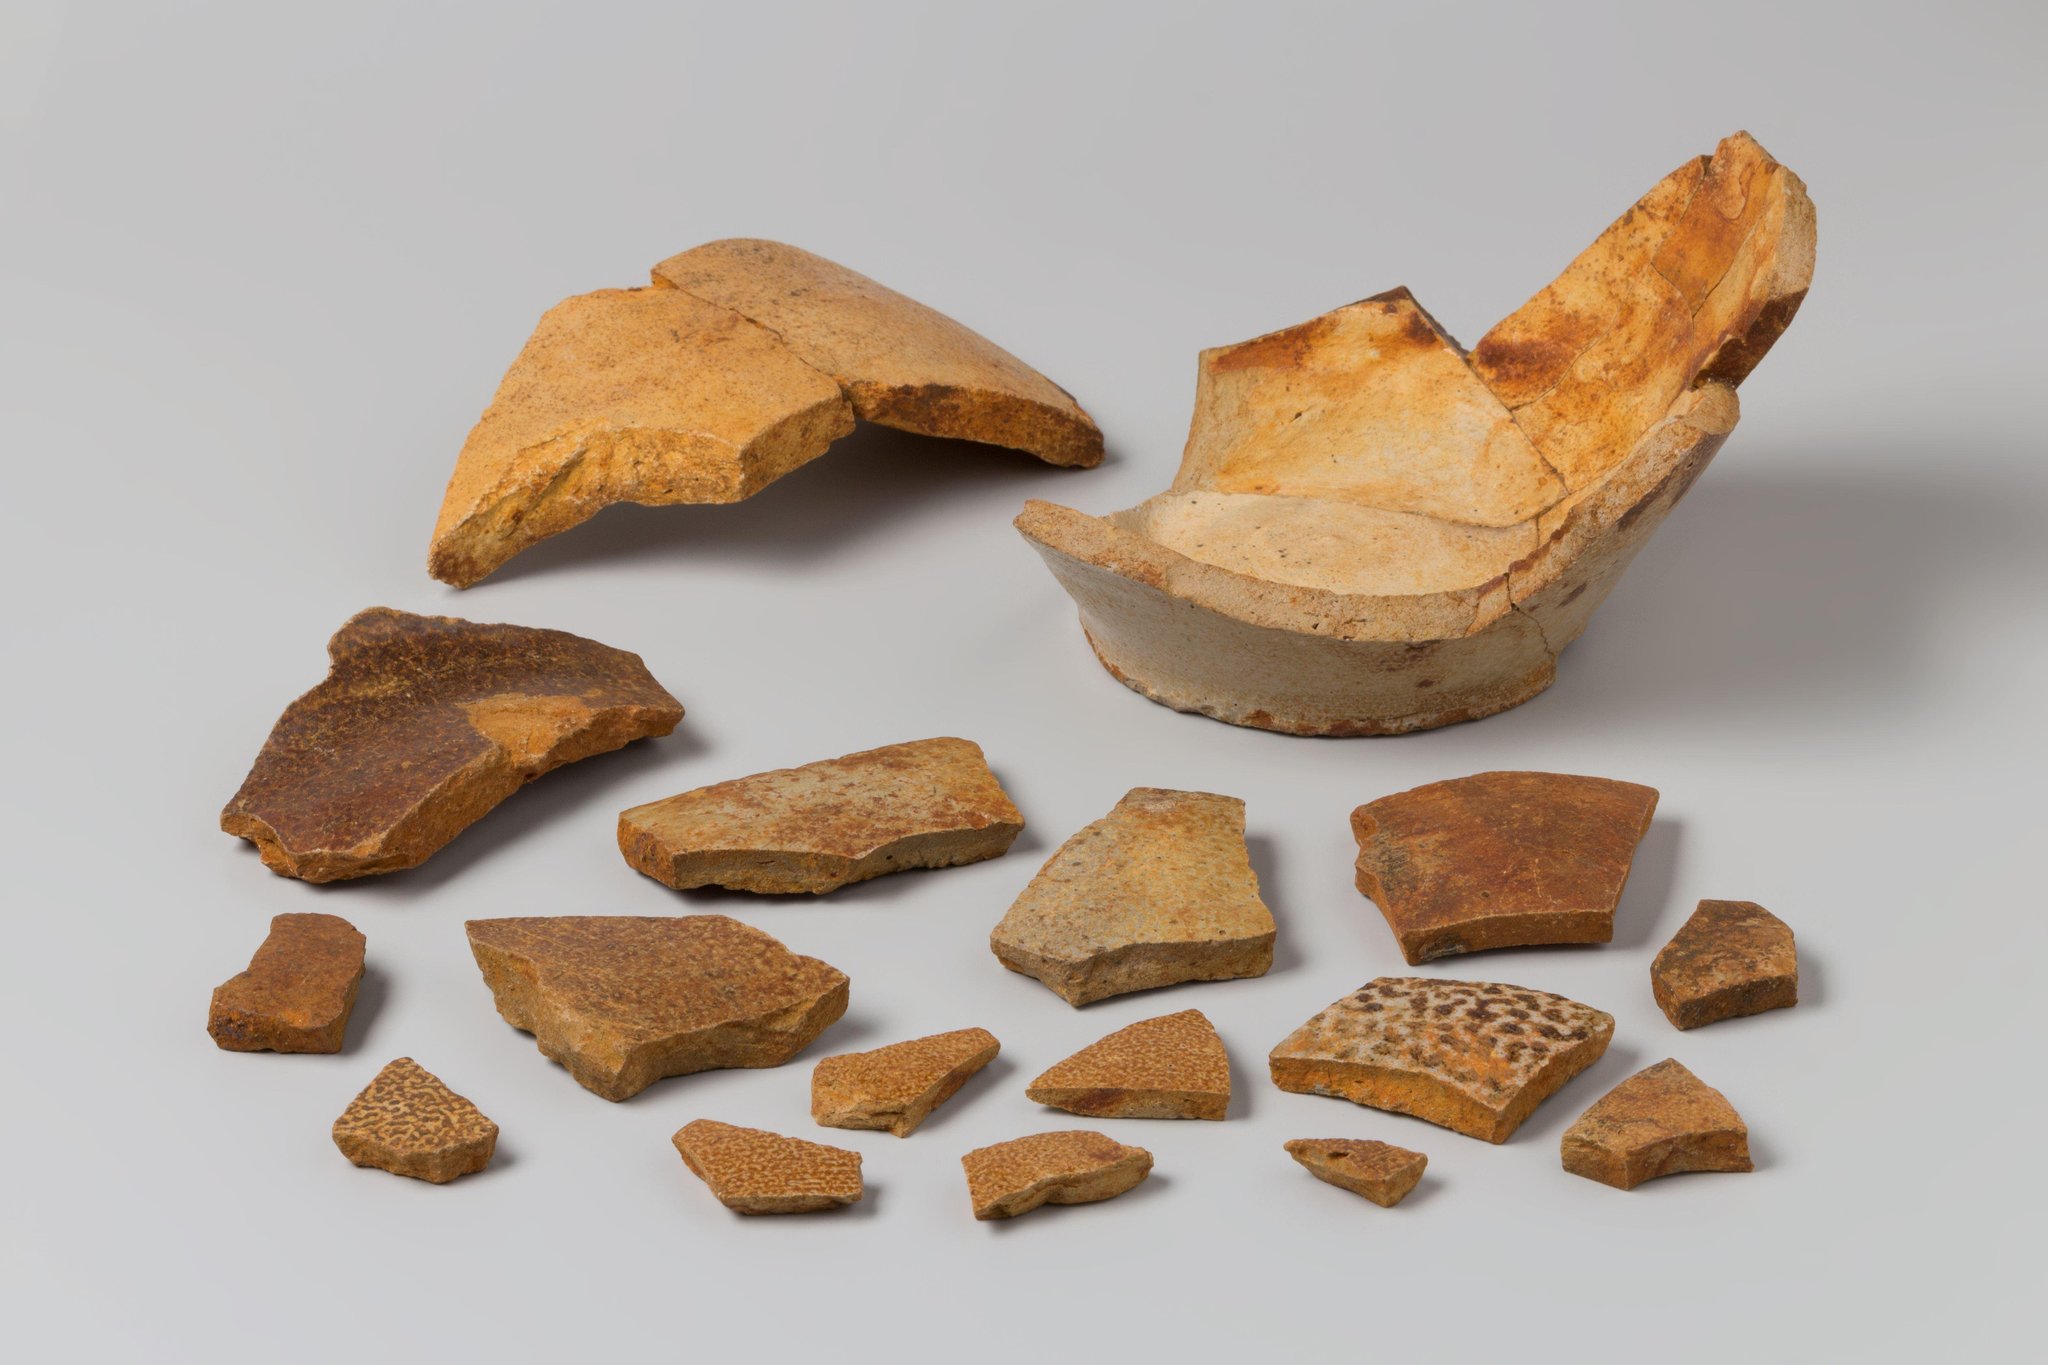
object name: sherd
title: Scherven van kannen uit het wrak van de Oost-Indiëvaarder Hollandia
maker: Anonymous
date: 1700-1743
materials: stoneware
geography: cologne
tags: verenigde oostindische compagnie, hollandia (schip), annet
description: Stoneware, Rhenish, Frechen-ware, jug; fragm of base, with flaring body, fragm of bodies.